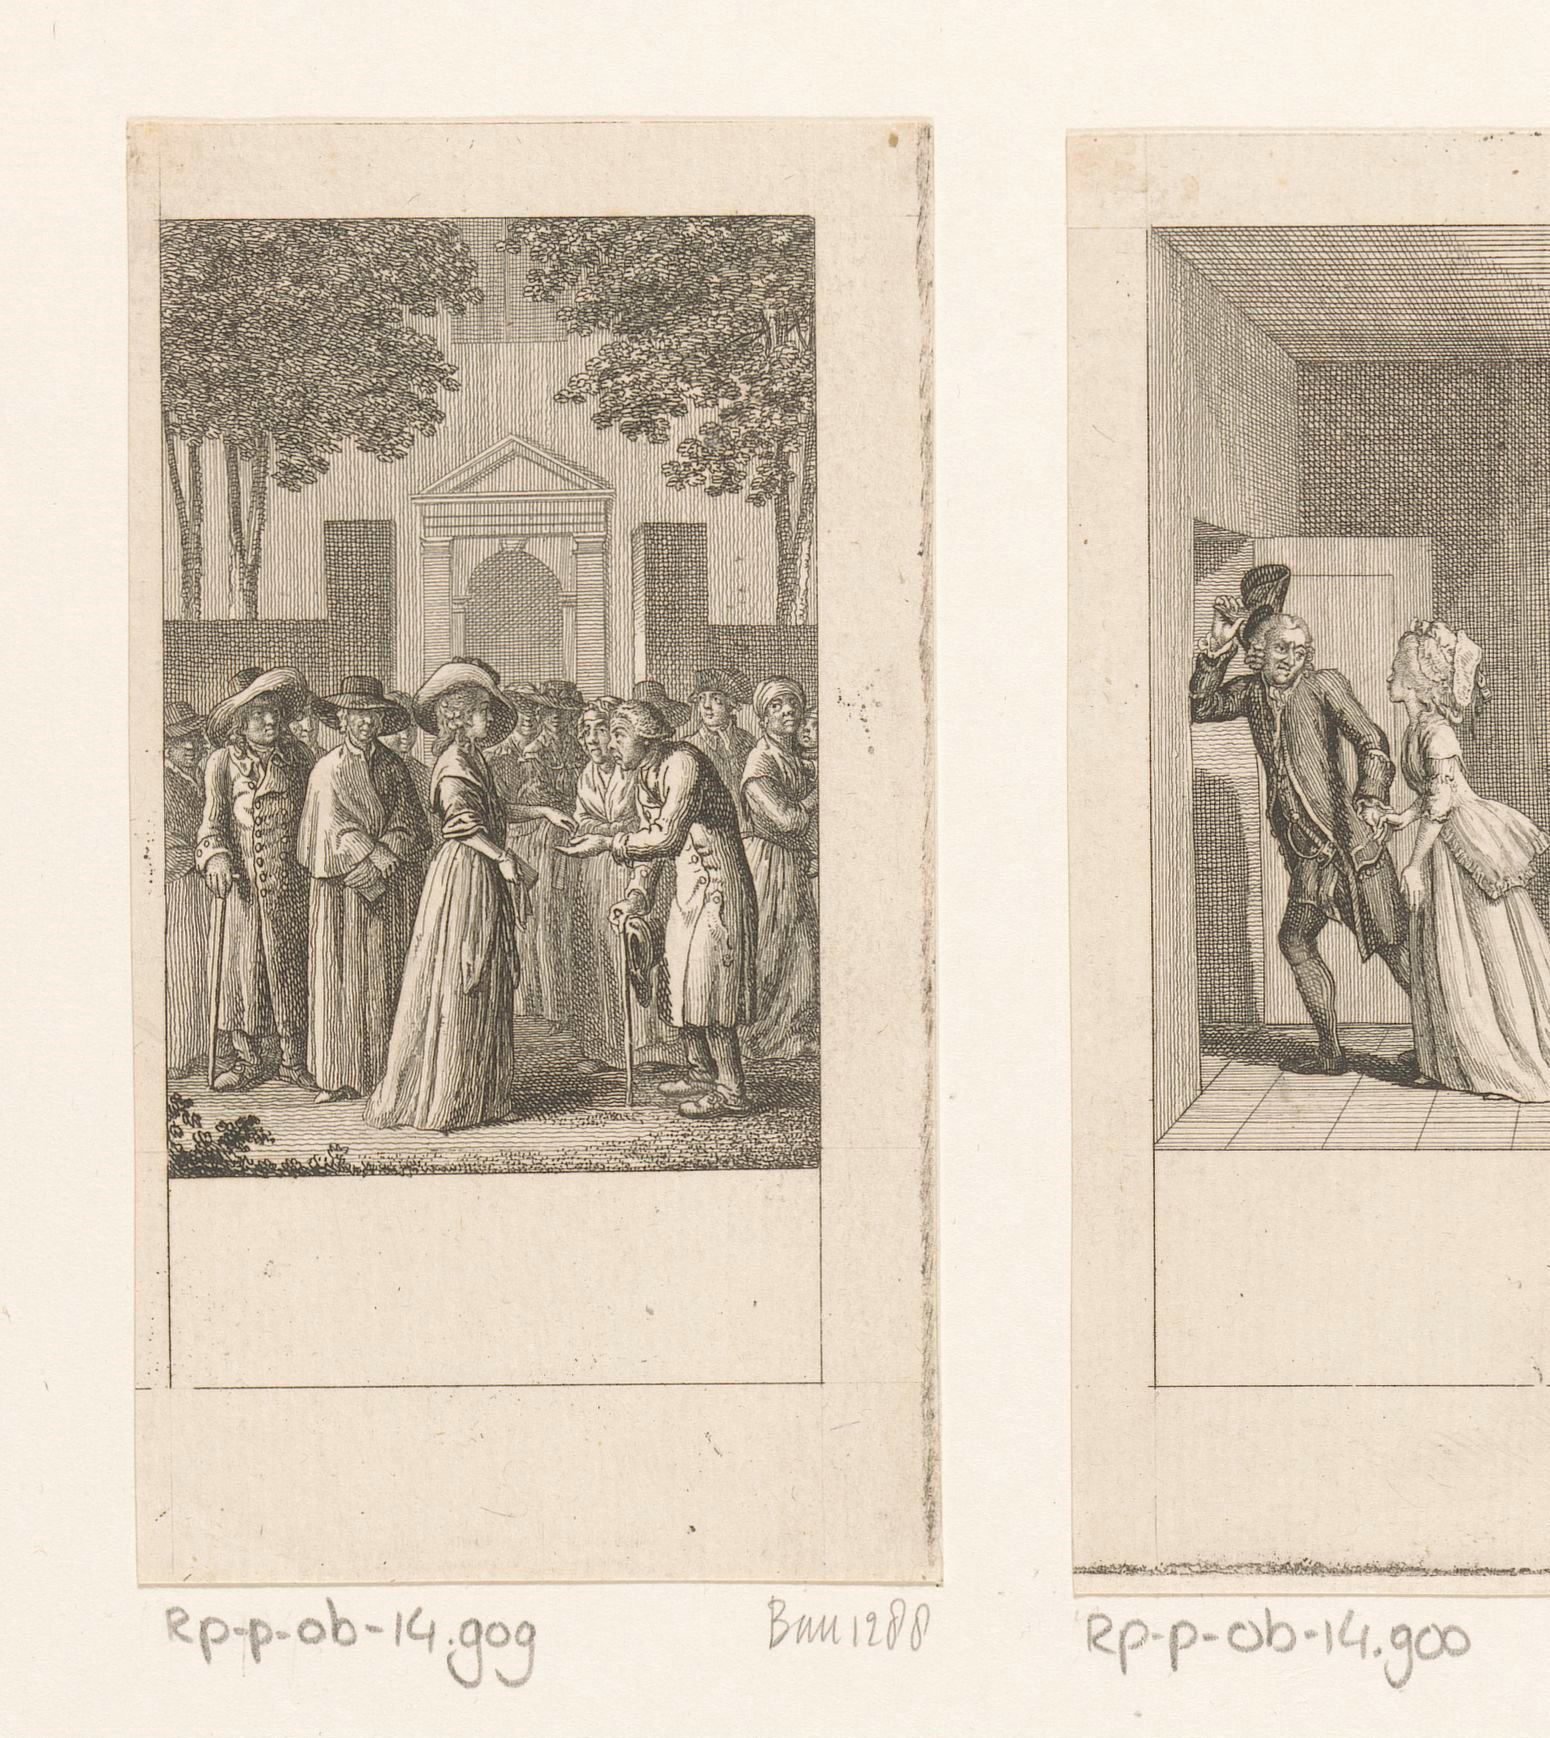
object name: print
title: Camille laat de dorpelingen geloven dat ze de welvarende dochter van een Lord is en geeft aalmoezen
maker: daniel nikolaus chodowiecki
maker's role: draughtsman, print maker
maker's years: 1726-1801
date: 1787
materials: paper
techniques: etching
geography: berlin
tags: city-view, and landscape with man-made constructions, literature, going to church, giving alms; collection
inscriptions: collector's mark: Lugt 2228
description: Vervaardigd voor J. F. Jünger's vertaling van 'Camille: oder, Briefe zweyer Mädchen aus unserm Zeitalter'. Een latere staat gebruikt in: Genealogischer Taschenkalender. Auf das Jahr 1788. Berlijn: Königl. Academie der Wissenschaften, 1787.